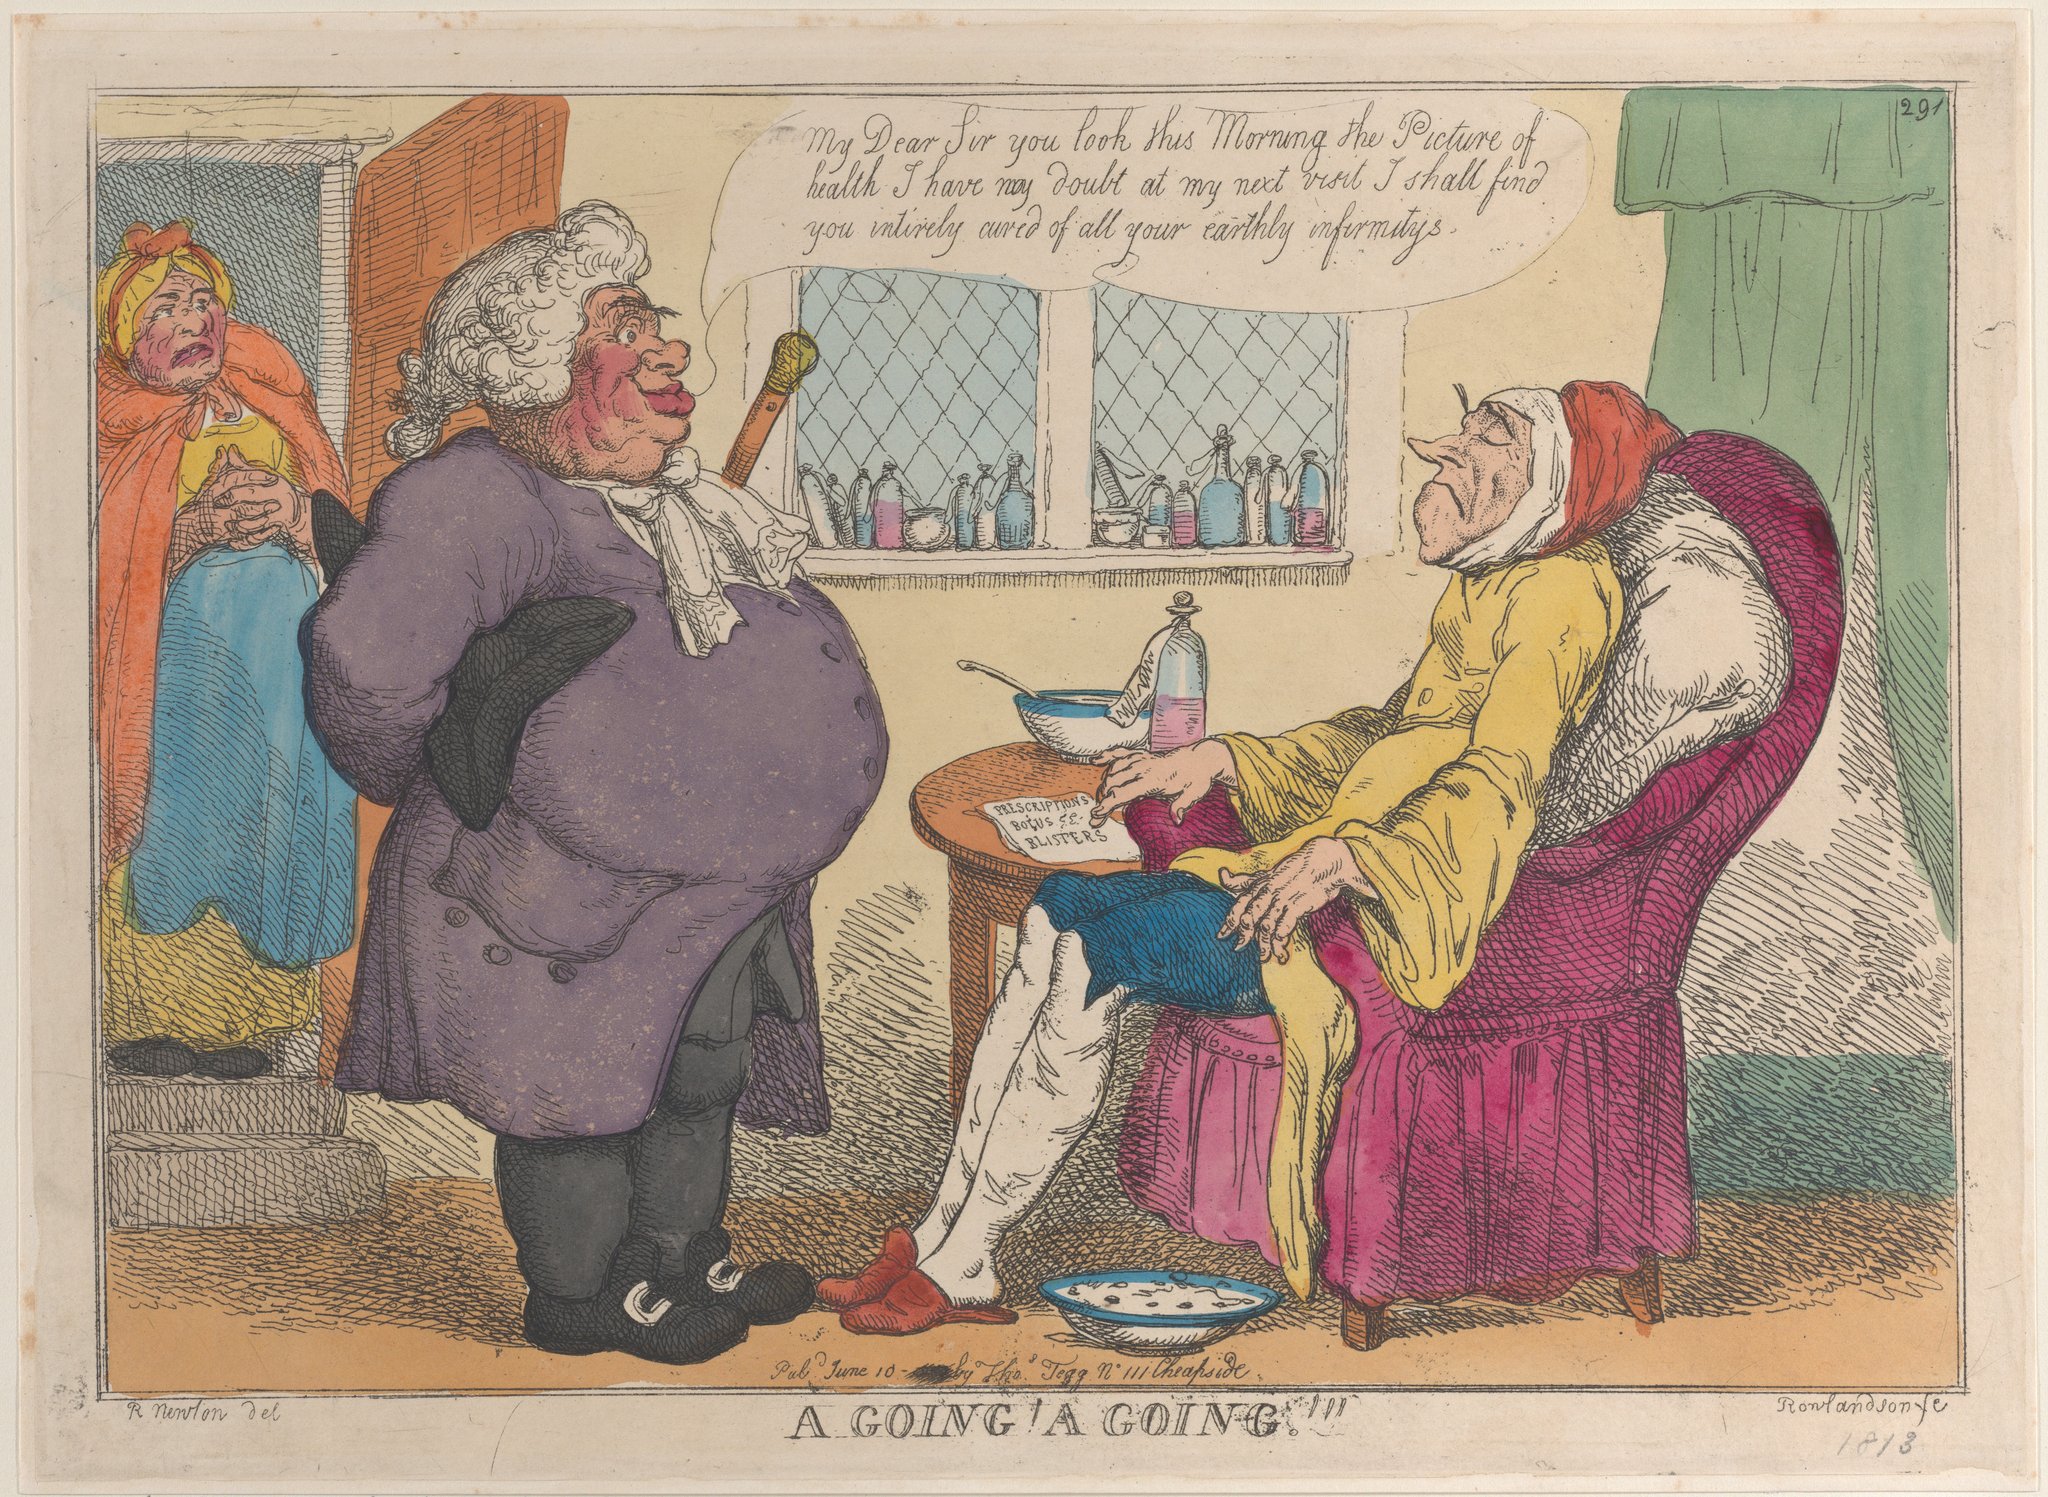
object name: print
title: A Going! A Going!!!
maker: thomas rowlandson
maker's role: artist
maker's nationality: british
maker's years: 1757-1827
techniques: etching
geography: london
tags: satire,illness,men,doctors